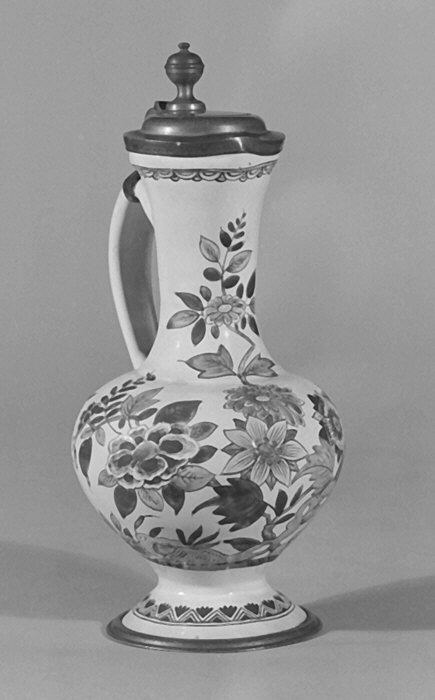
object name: jug with cover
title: Jug with pewter cover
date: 1730-1740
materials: earthenware, pewter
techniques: glazing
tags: flowers